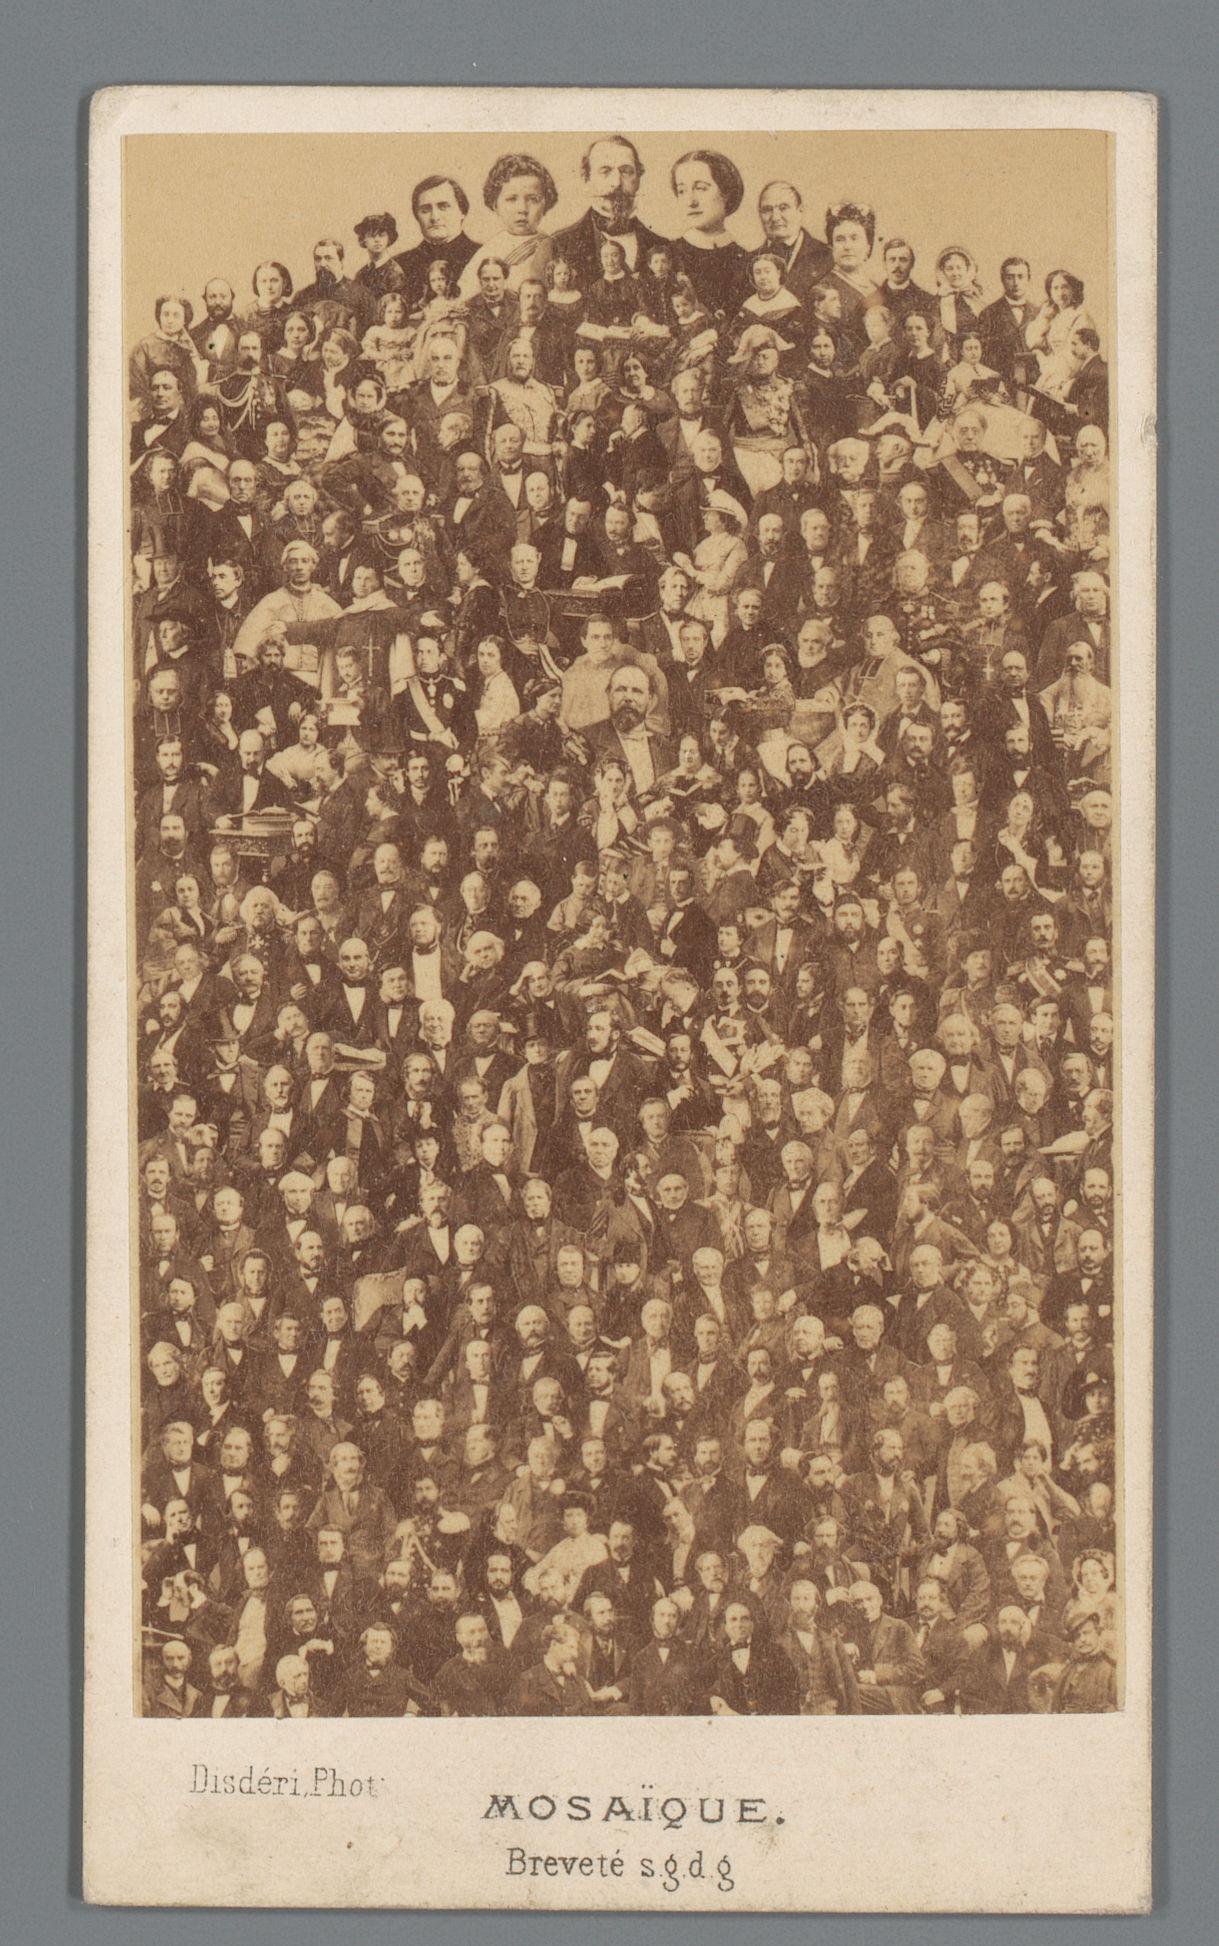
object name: carte de visite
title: Collage van miniatuurportretten van beroemde personen, midden bovenaan Karel Lodewijk Napoleon Bonaparte en diens echtgenote, Eugénie de Montijo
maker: andré-adolphe-eugène disdéri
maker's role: fotograaf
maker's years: 1819-1889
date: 1854-1889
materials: cardboard, paper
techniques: albumen print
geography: paris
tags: sevilla, paris, london, napoleon iii (keizer der fransen), historical persons, france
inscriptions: inscription: ‘Breveté s.g.d.g’, address: ‘8, Boulevart des Italiens/ PARIS’